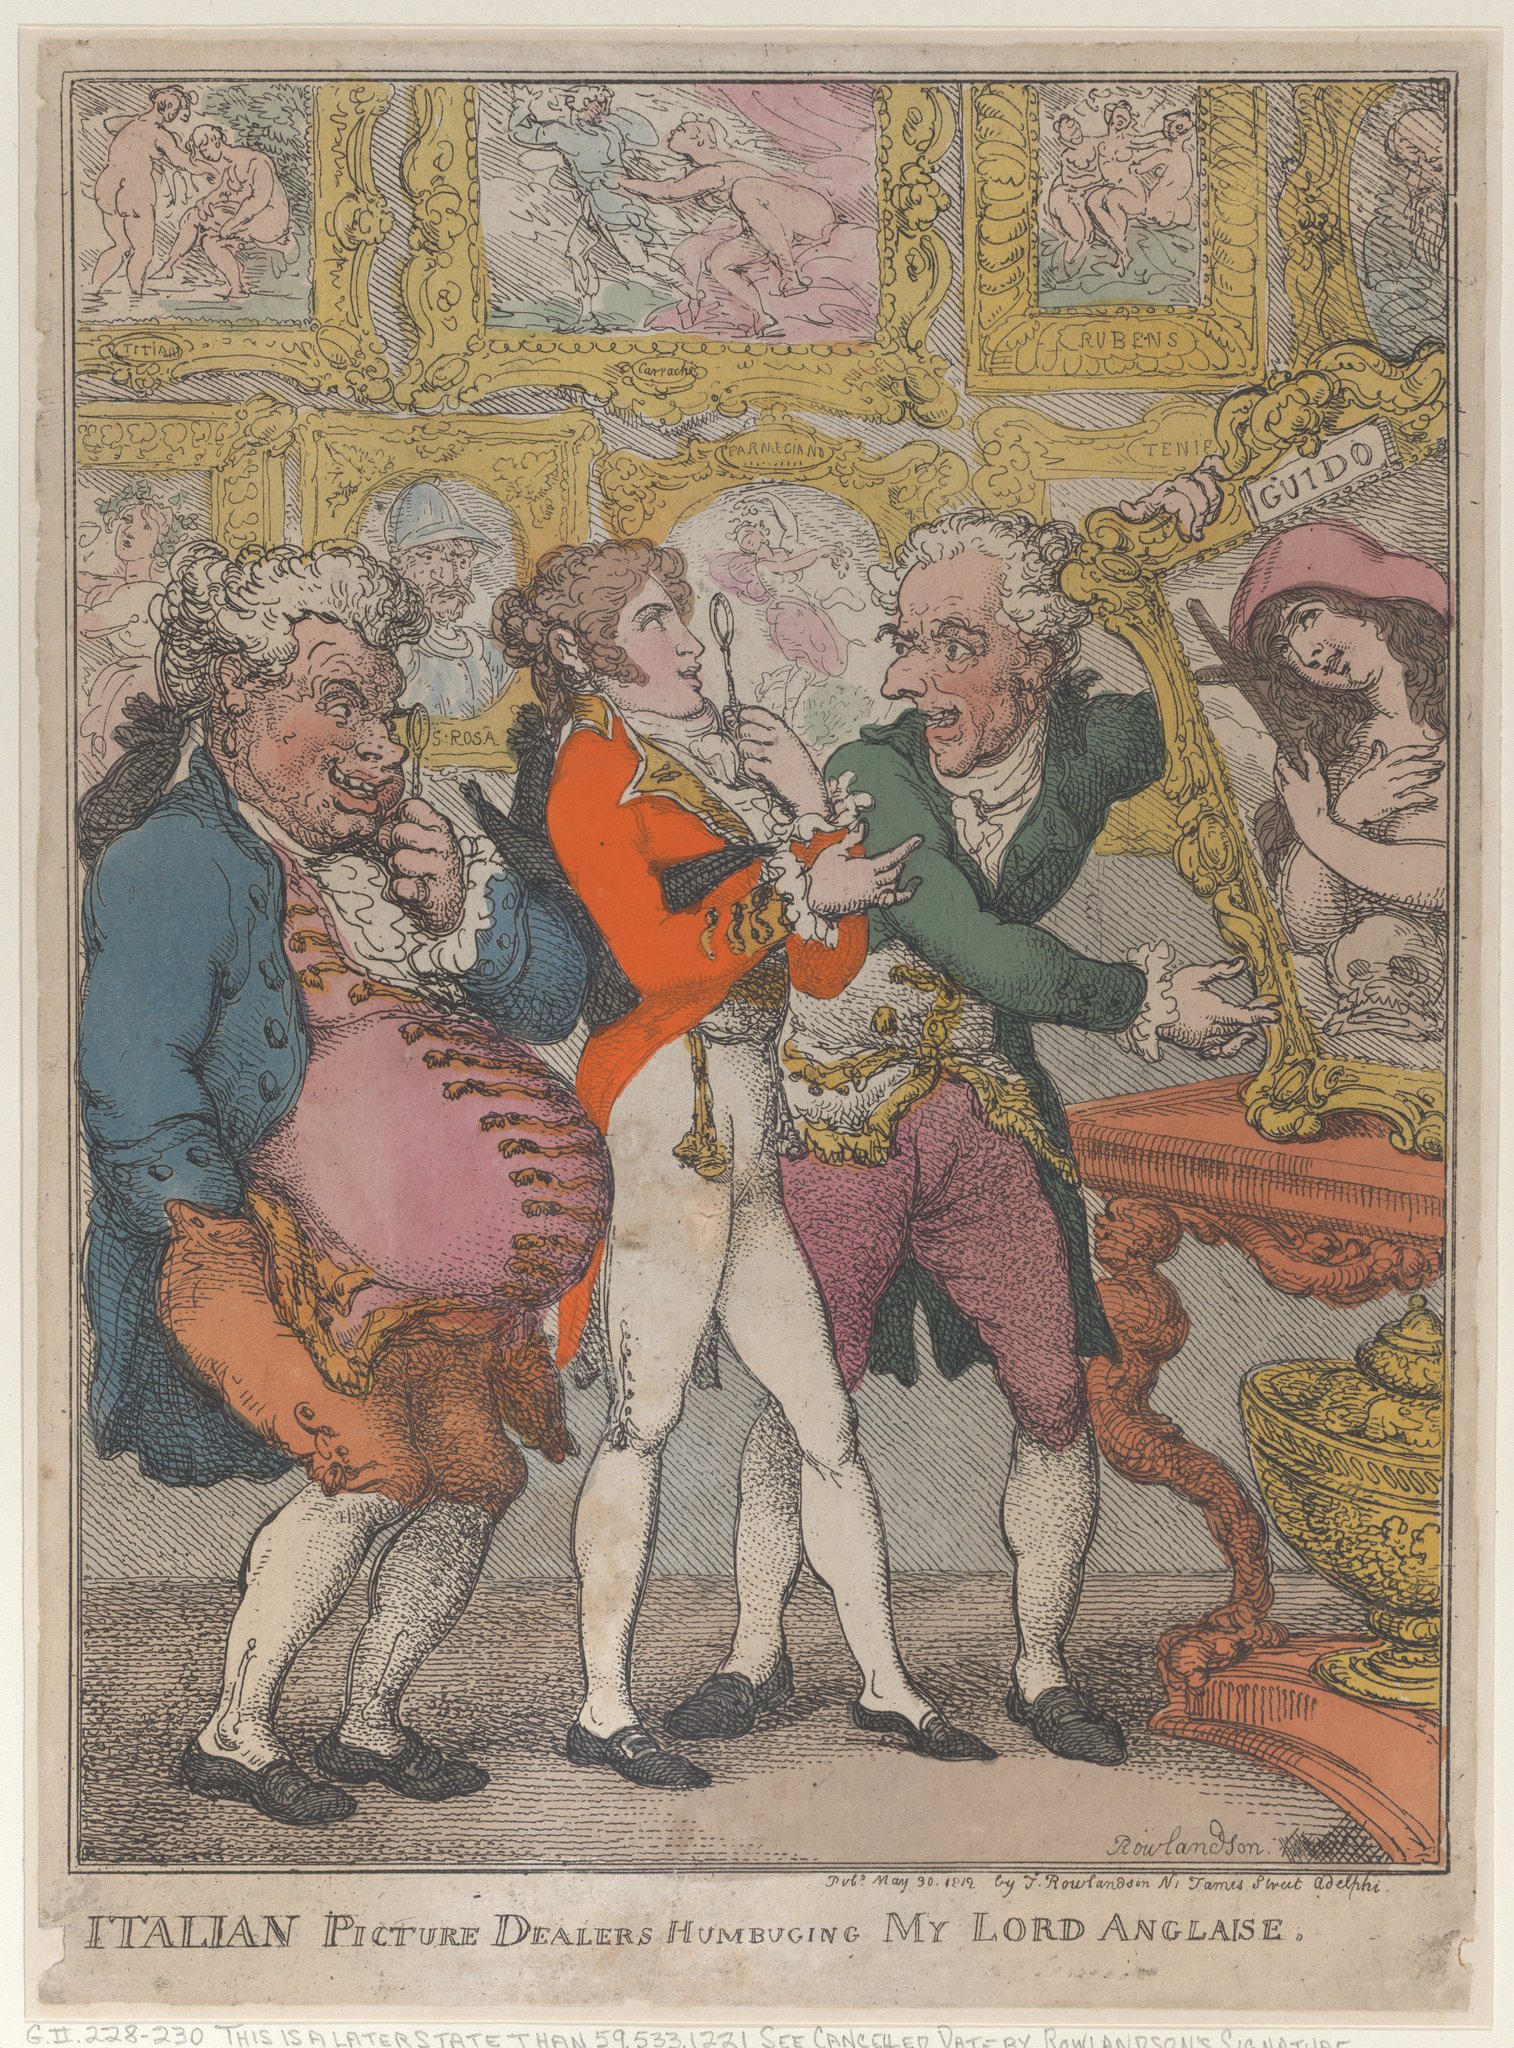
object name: print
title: Italian Picture Dealers Humbugging My Lord Anglaise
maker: thomas rowlandson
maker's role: artist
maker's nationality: british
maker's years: 1757-1827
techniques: etching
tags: satire,men